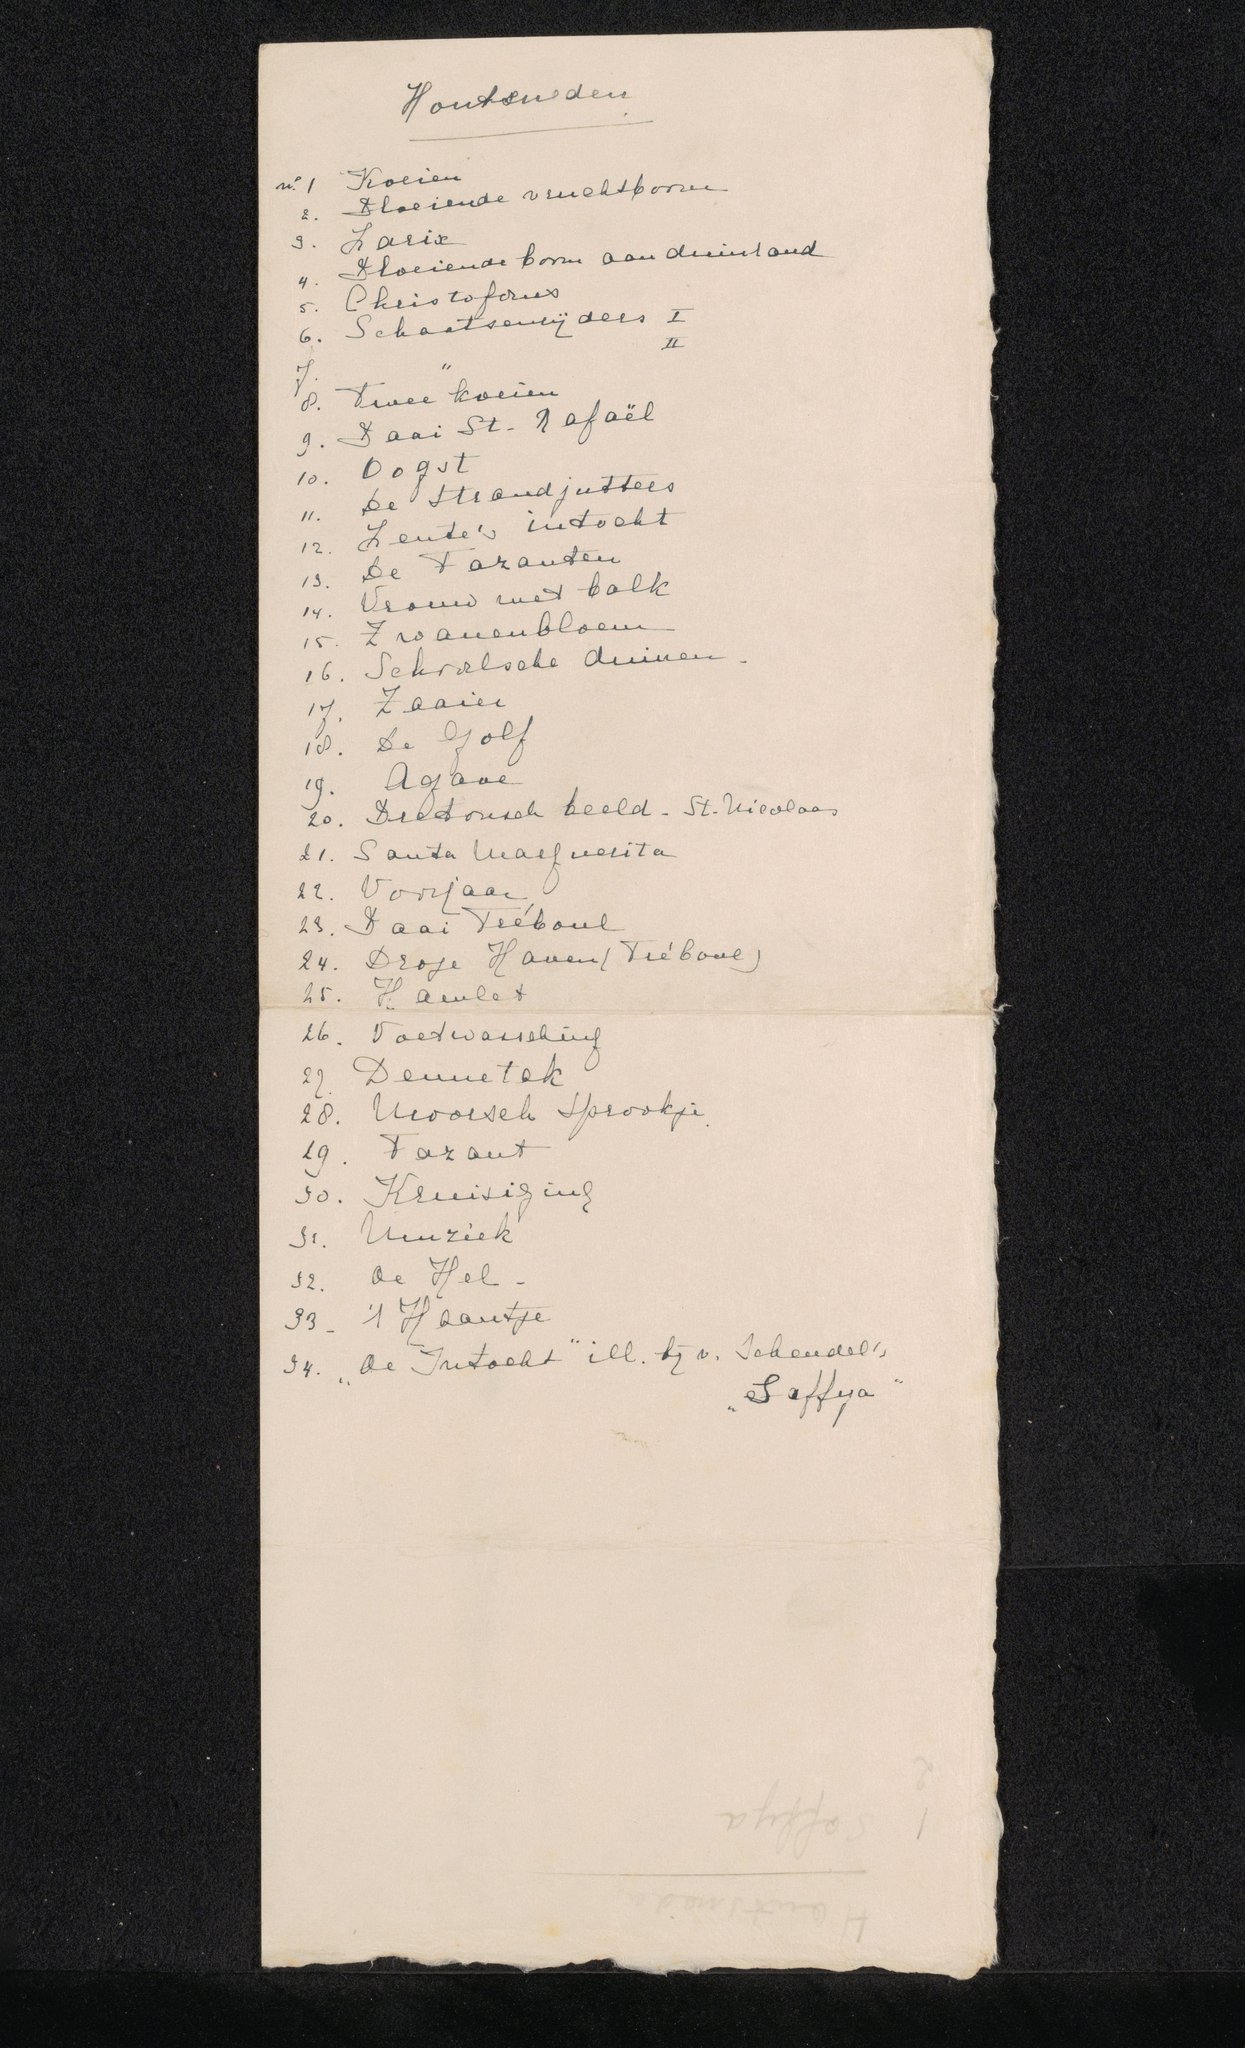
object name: manuscript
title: Lijst met houtsneden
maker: bernard essers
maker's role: print maker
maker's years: 1893-1945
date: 1903-1945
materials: ink, paper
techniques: pen, writing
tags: the graphic arts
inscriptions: collector's mark: ‘RPK’